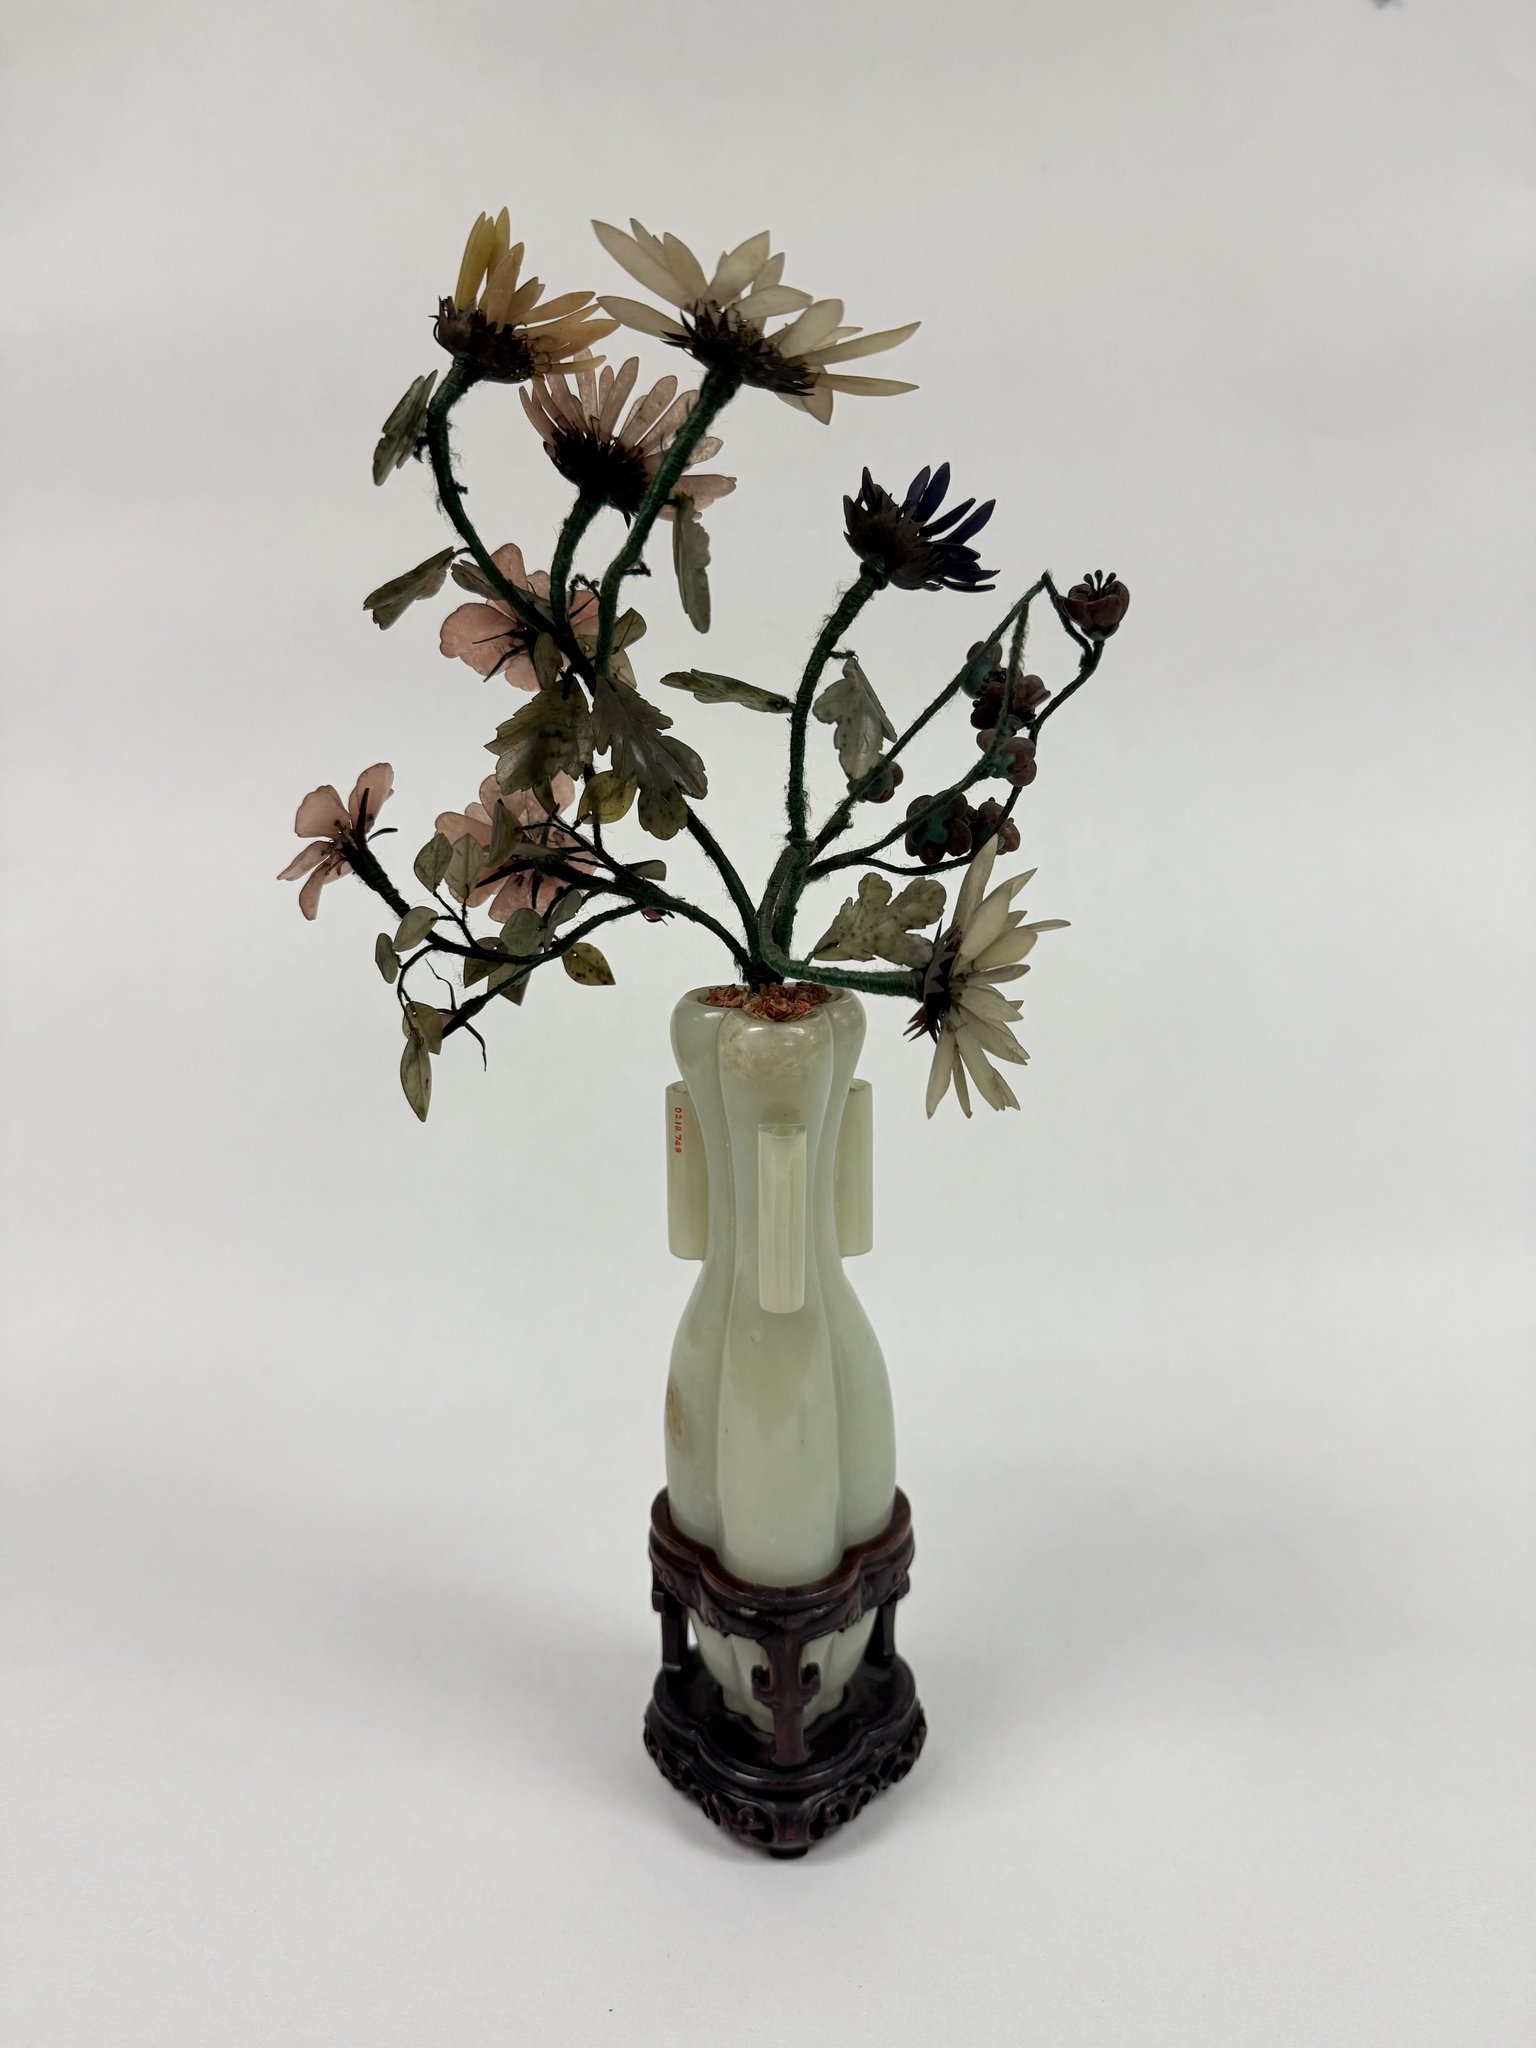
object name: flower vase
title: Vase with Flowers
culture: chinese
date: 1736-1795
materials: jade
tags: flowers